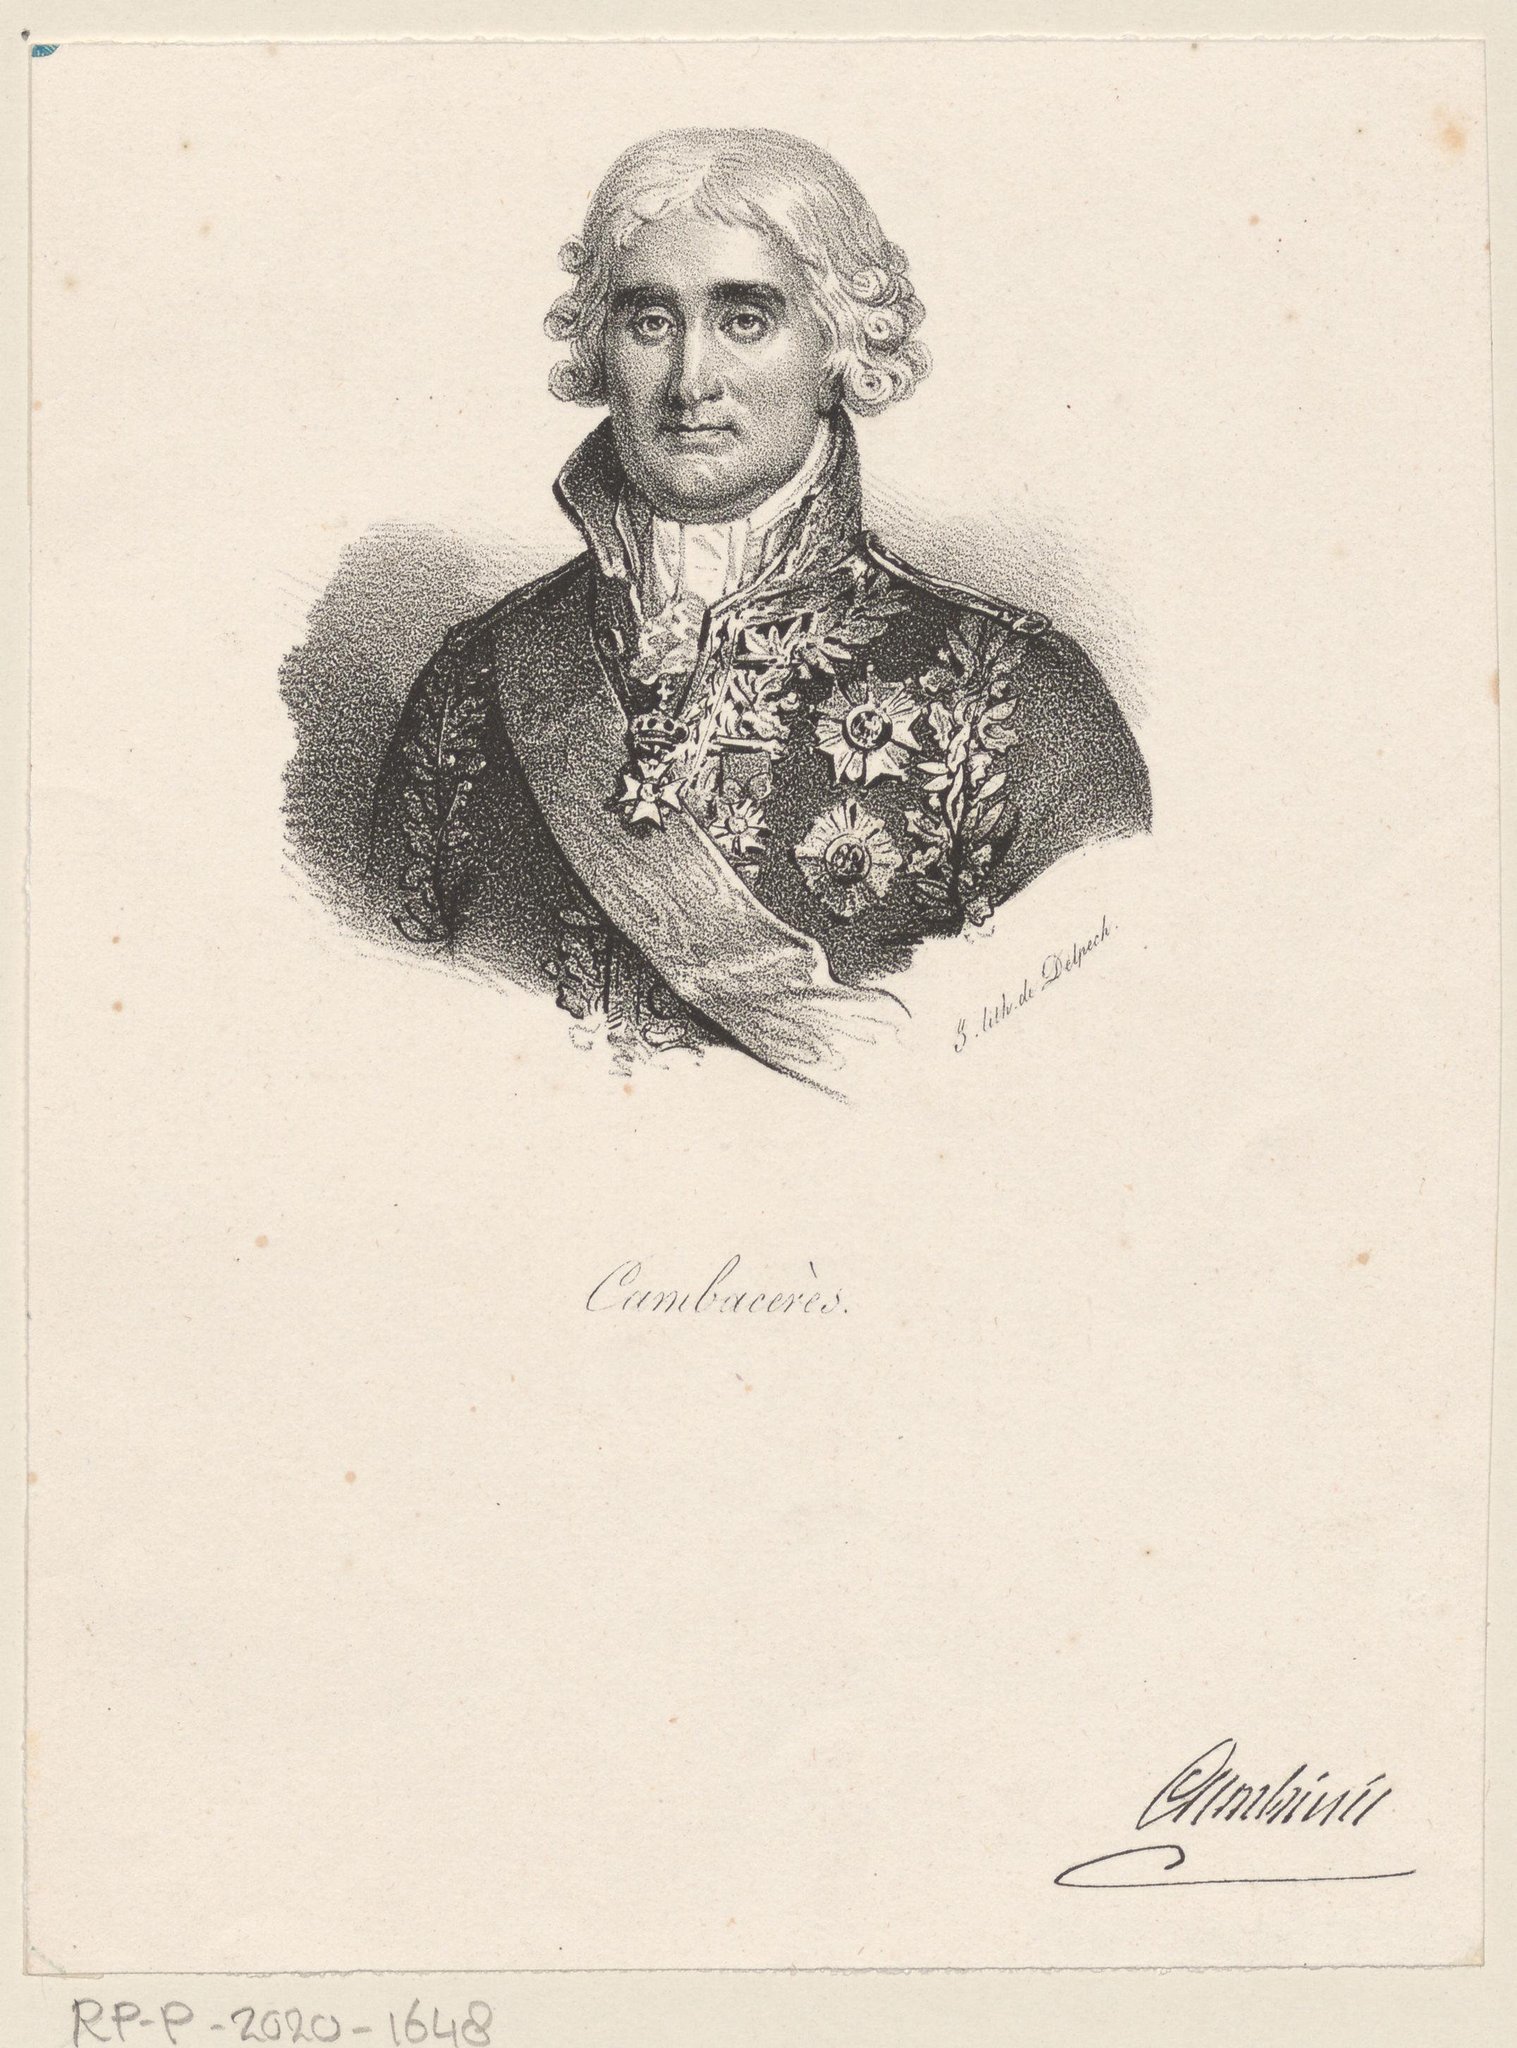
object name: print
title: Portret van Jean-Jacques Régis de Cambacérès, hertog van Parma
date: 1818-1825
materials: paper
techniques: lithograph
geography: paris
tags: paris, politician, historical persons